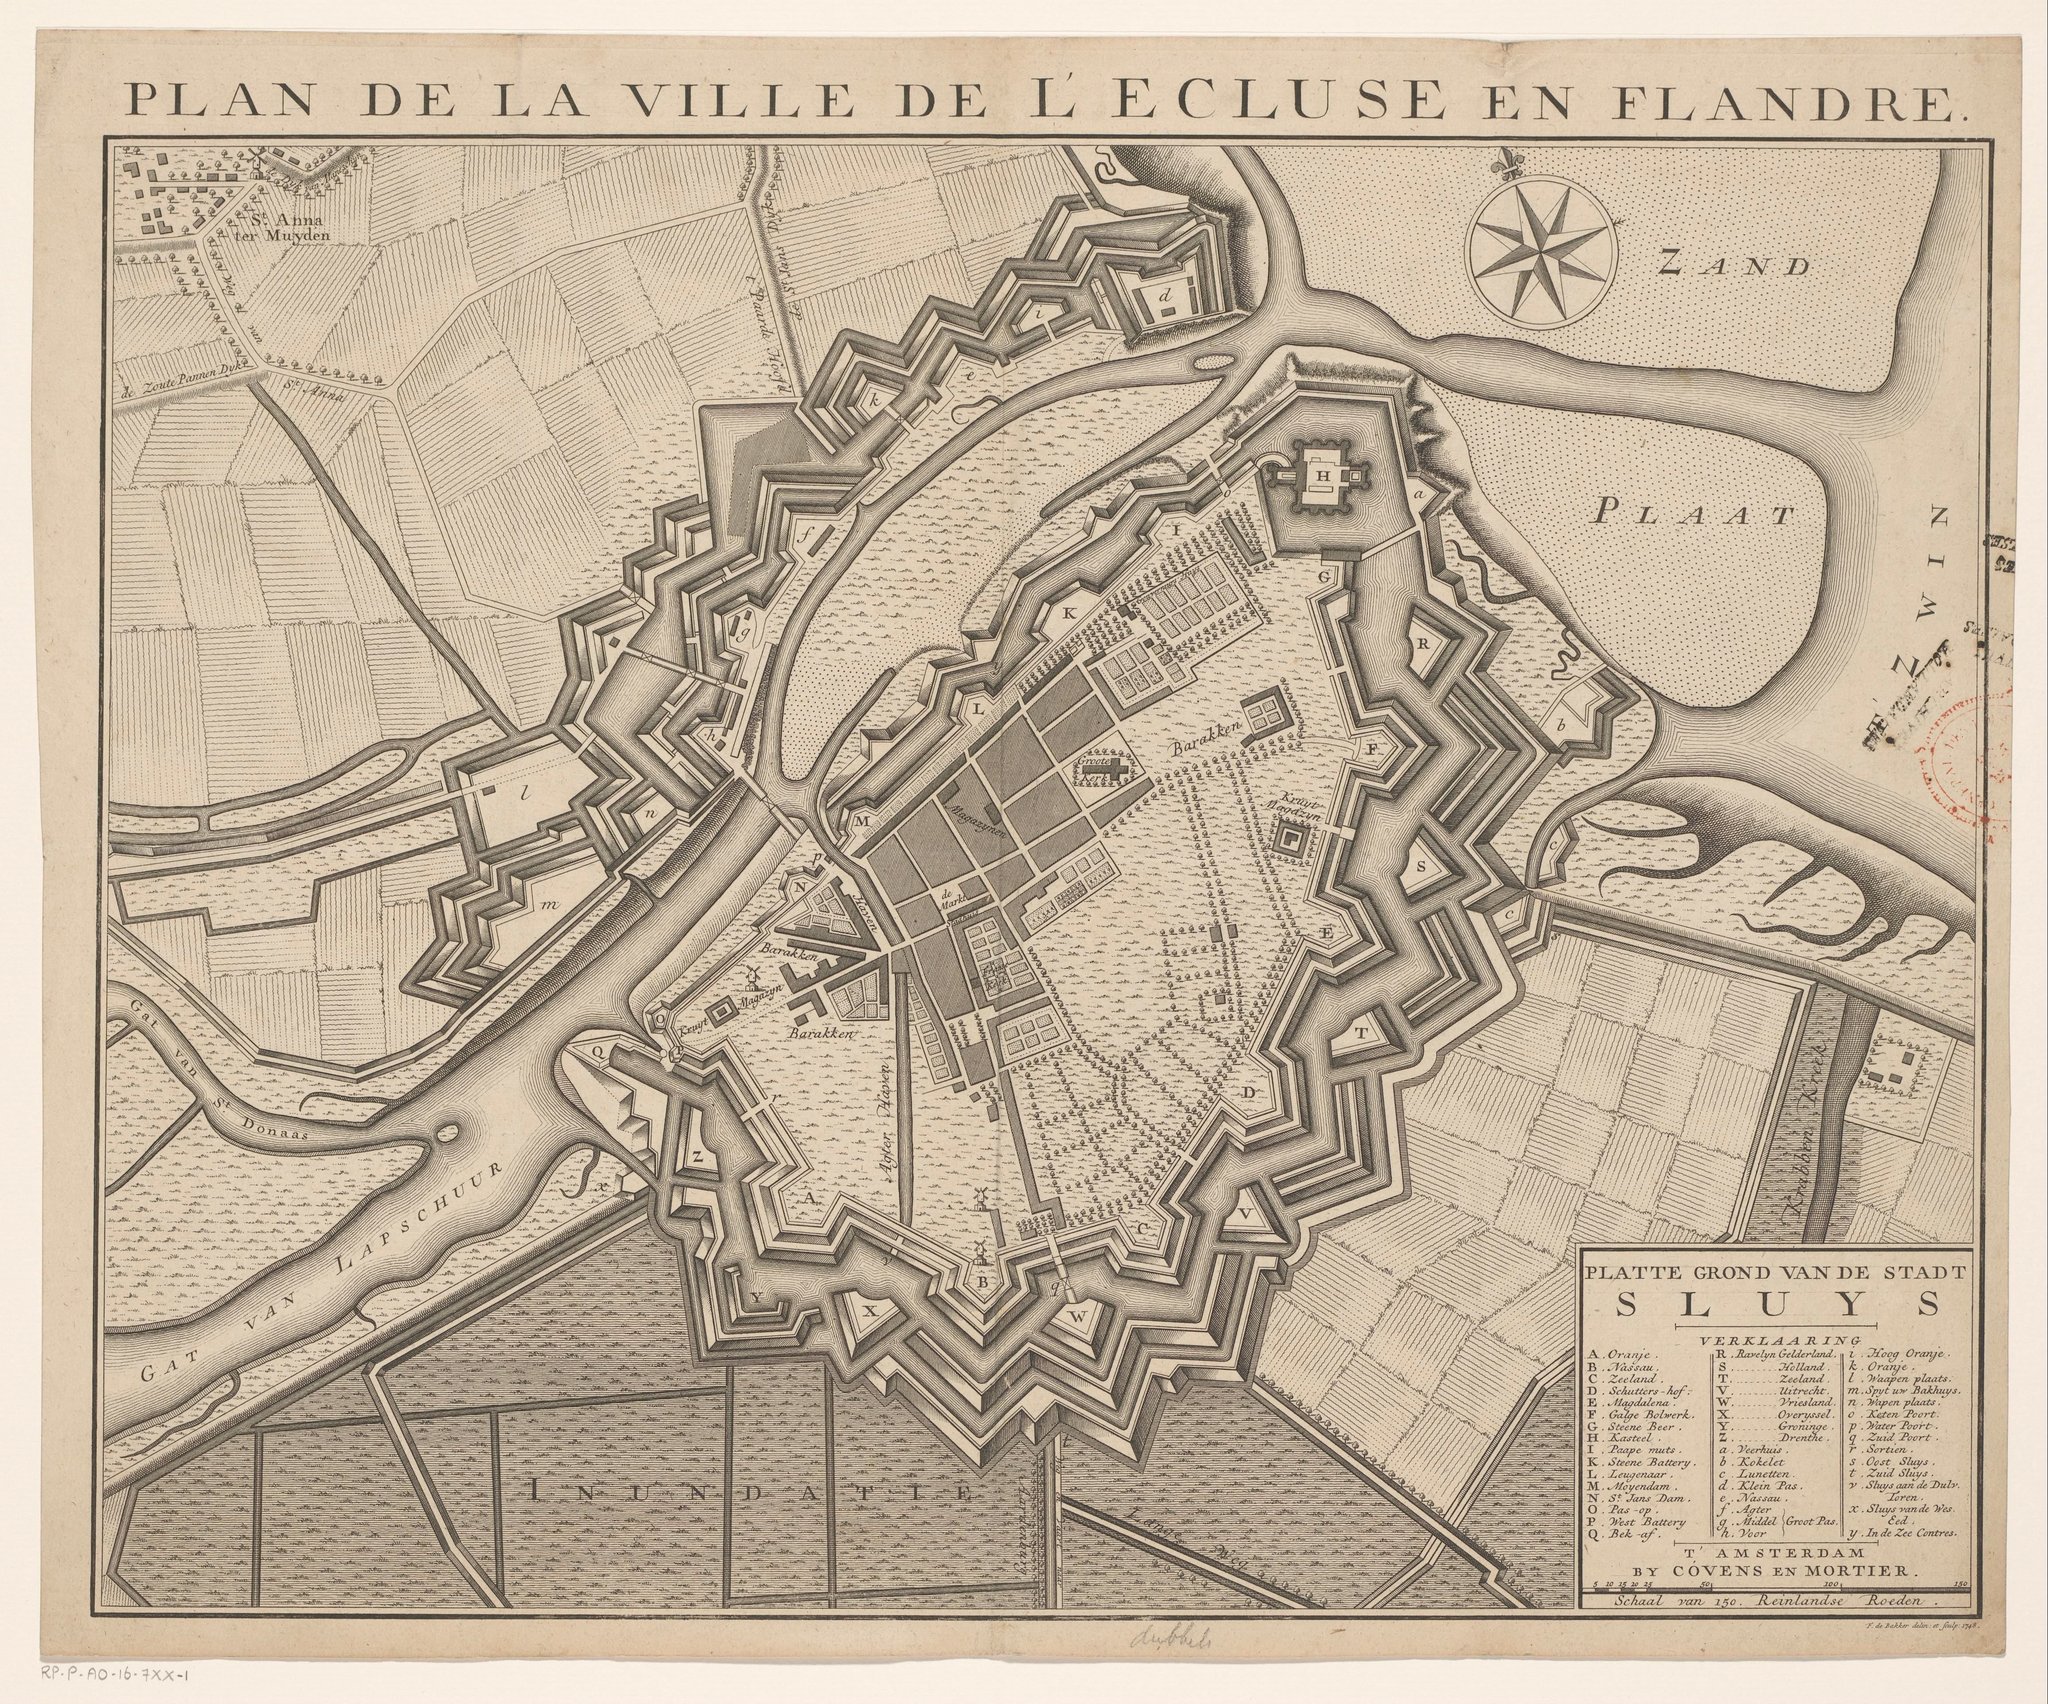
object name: area plan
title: Vestingplattegrond van Sluis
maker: frans de bakker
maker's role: print maker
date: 1748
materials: paper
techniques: engraving, etching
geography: amsterdam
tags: fortified city, maps of cities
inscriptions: collector's mark: ‘DEPOT GENERAL DES FORTIFICATIONS’, collector's mark: ‘ARCHIVES HOLLANDAISES’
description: Vestingplattegrond van Sluis. Rechtsonder een cartouche met de Nederlandse titel en een legenda A-Z en a-y. Boven de kaart de titel in het Frans. Rechtsonder een schaalstok: Schaal van 150 Reinlandse Roeden.